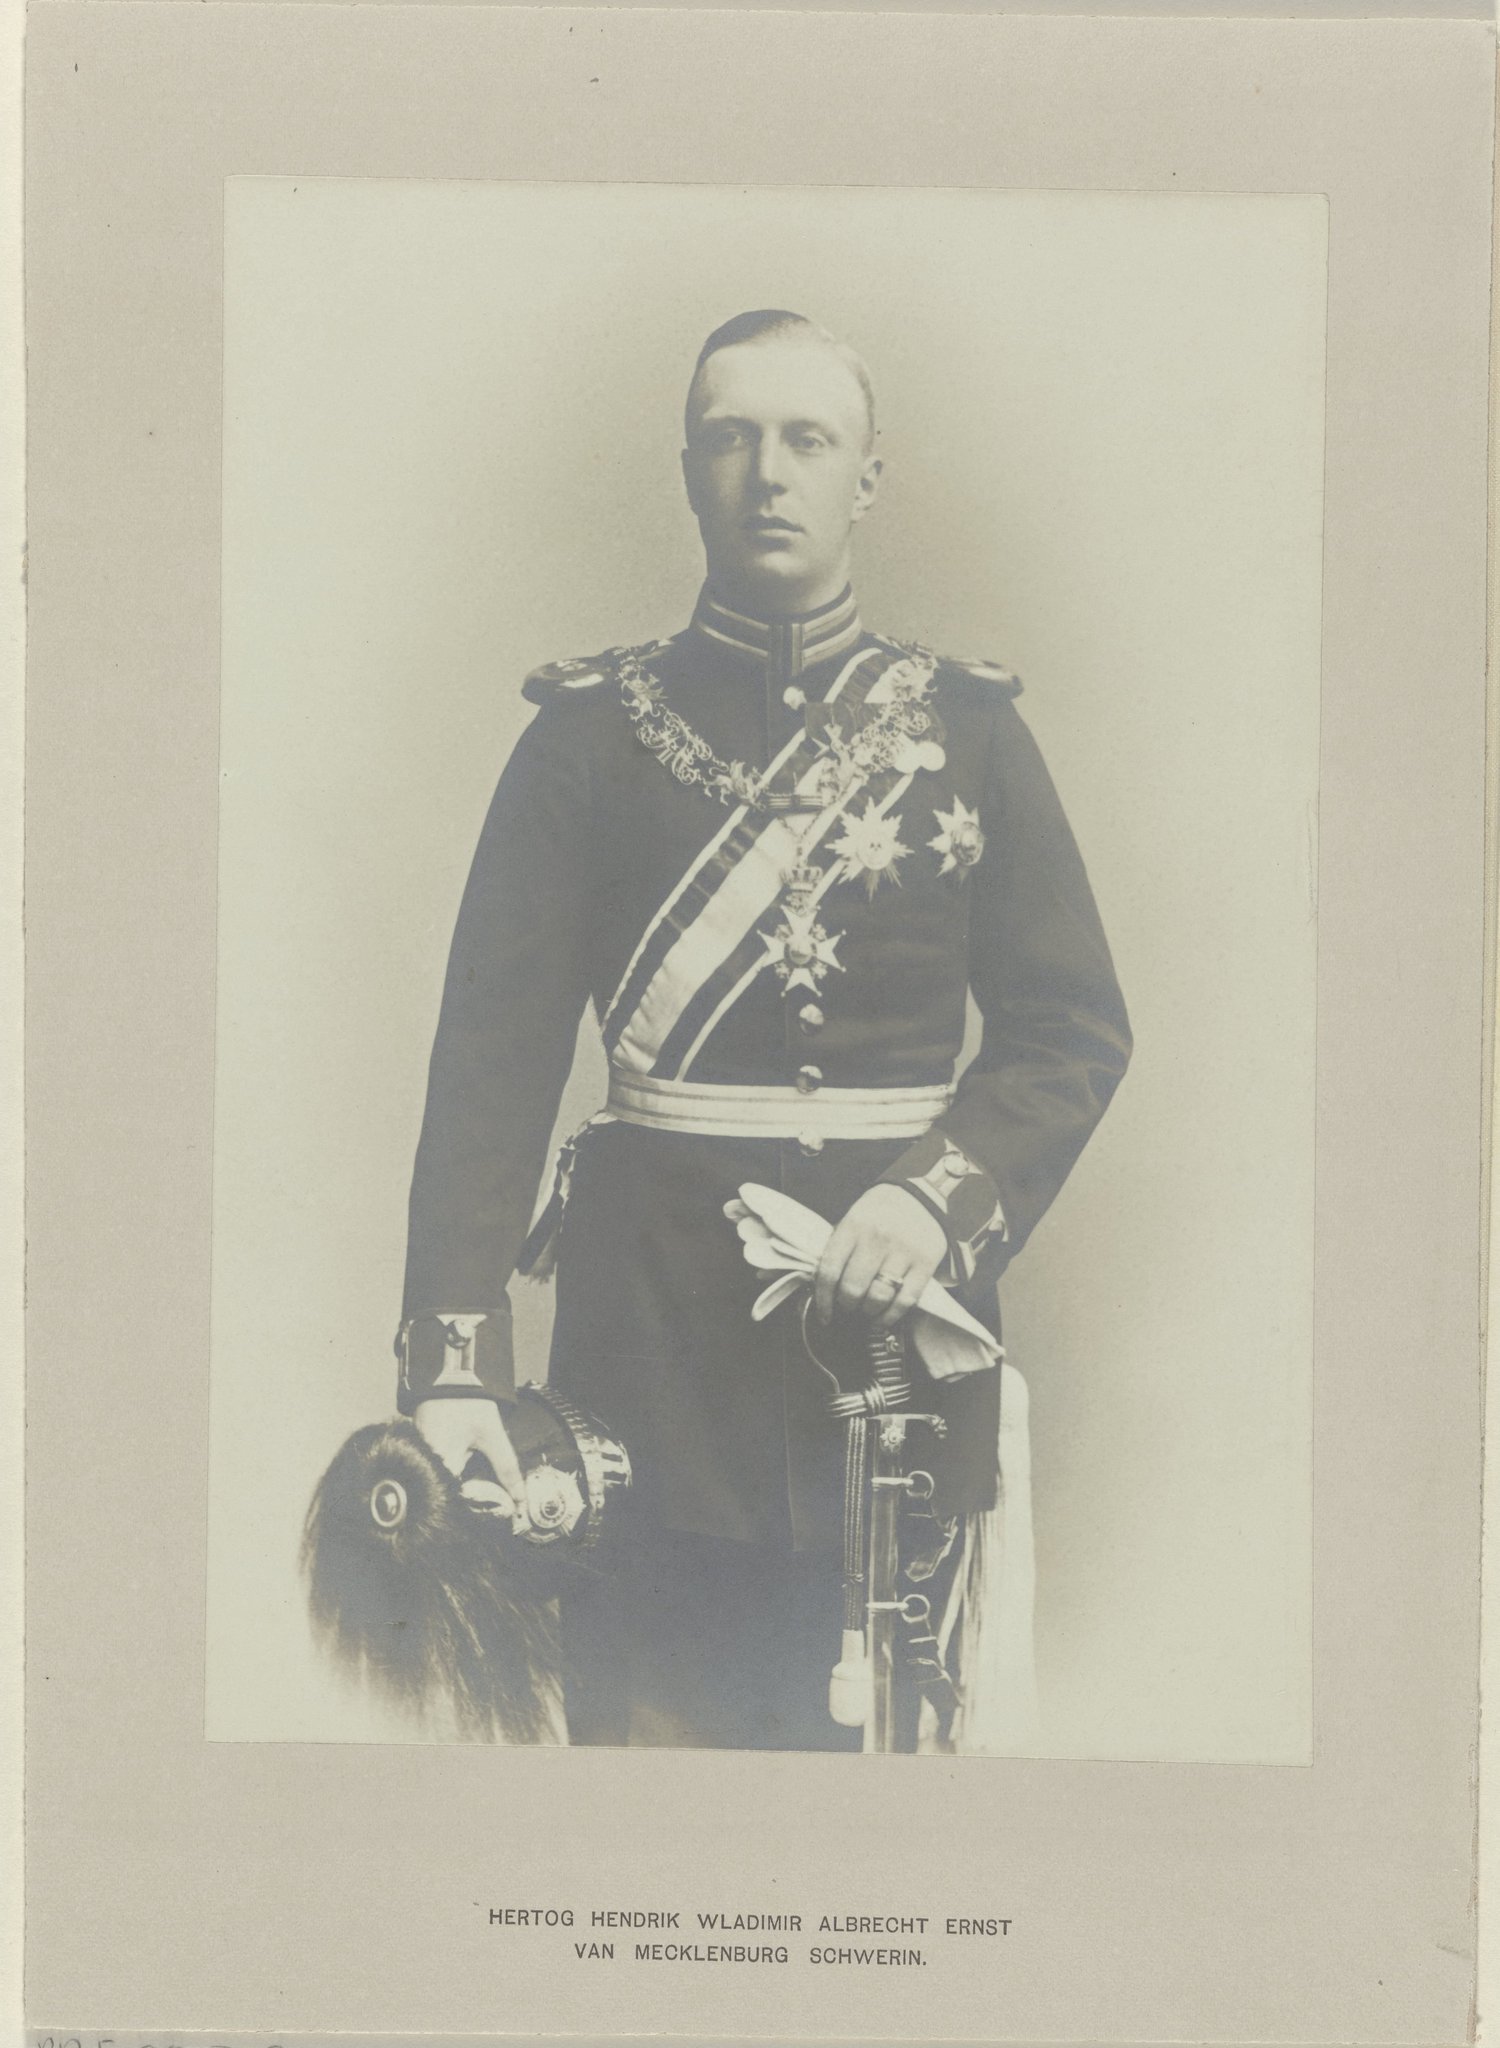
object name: photograph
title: Portret van Hendrik van Mecklenburg-Schwerin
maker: m.m. couvée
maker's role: publisher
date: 1900-1910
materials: cardboard, photographic support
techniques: photography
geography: the hague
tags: hendrik (prins der nederlanden (1876-1934))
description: Portret van Hendrik. In zijn linkerhand zijn handschoenen. In de ondermarge zijn naam en titel.